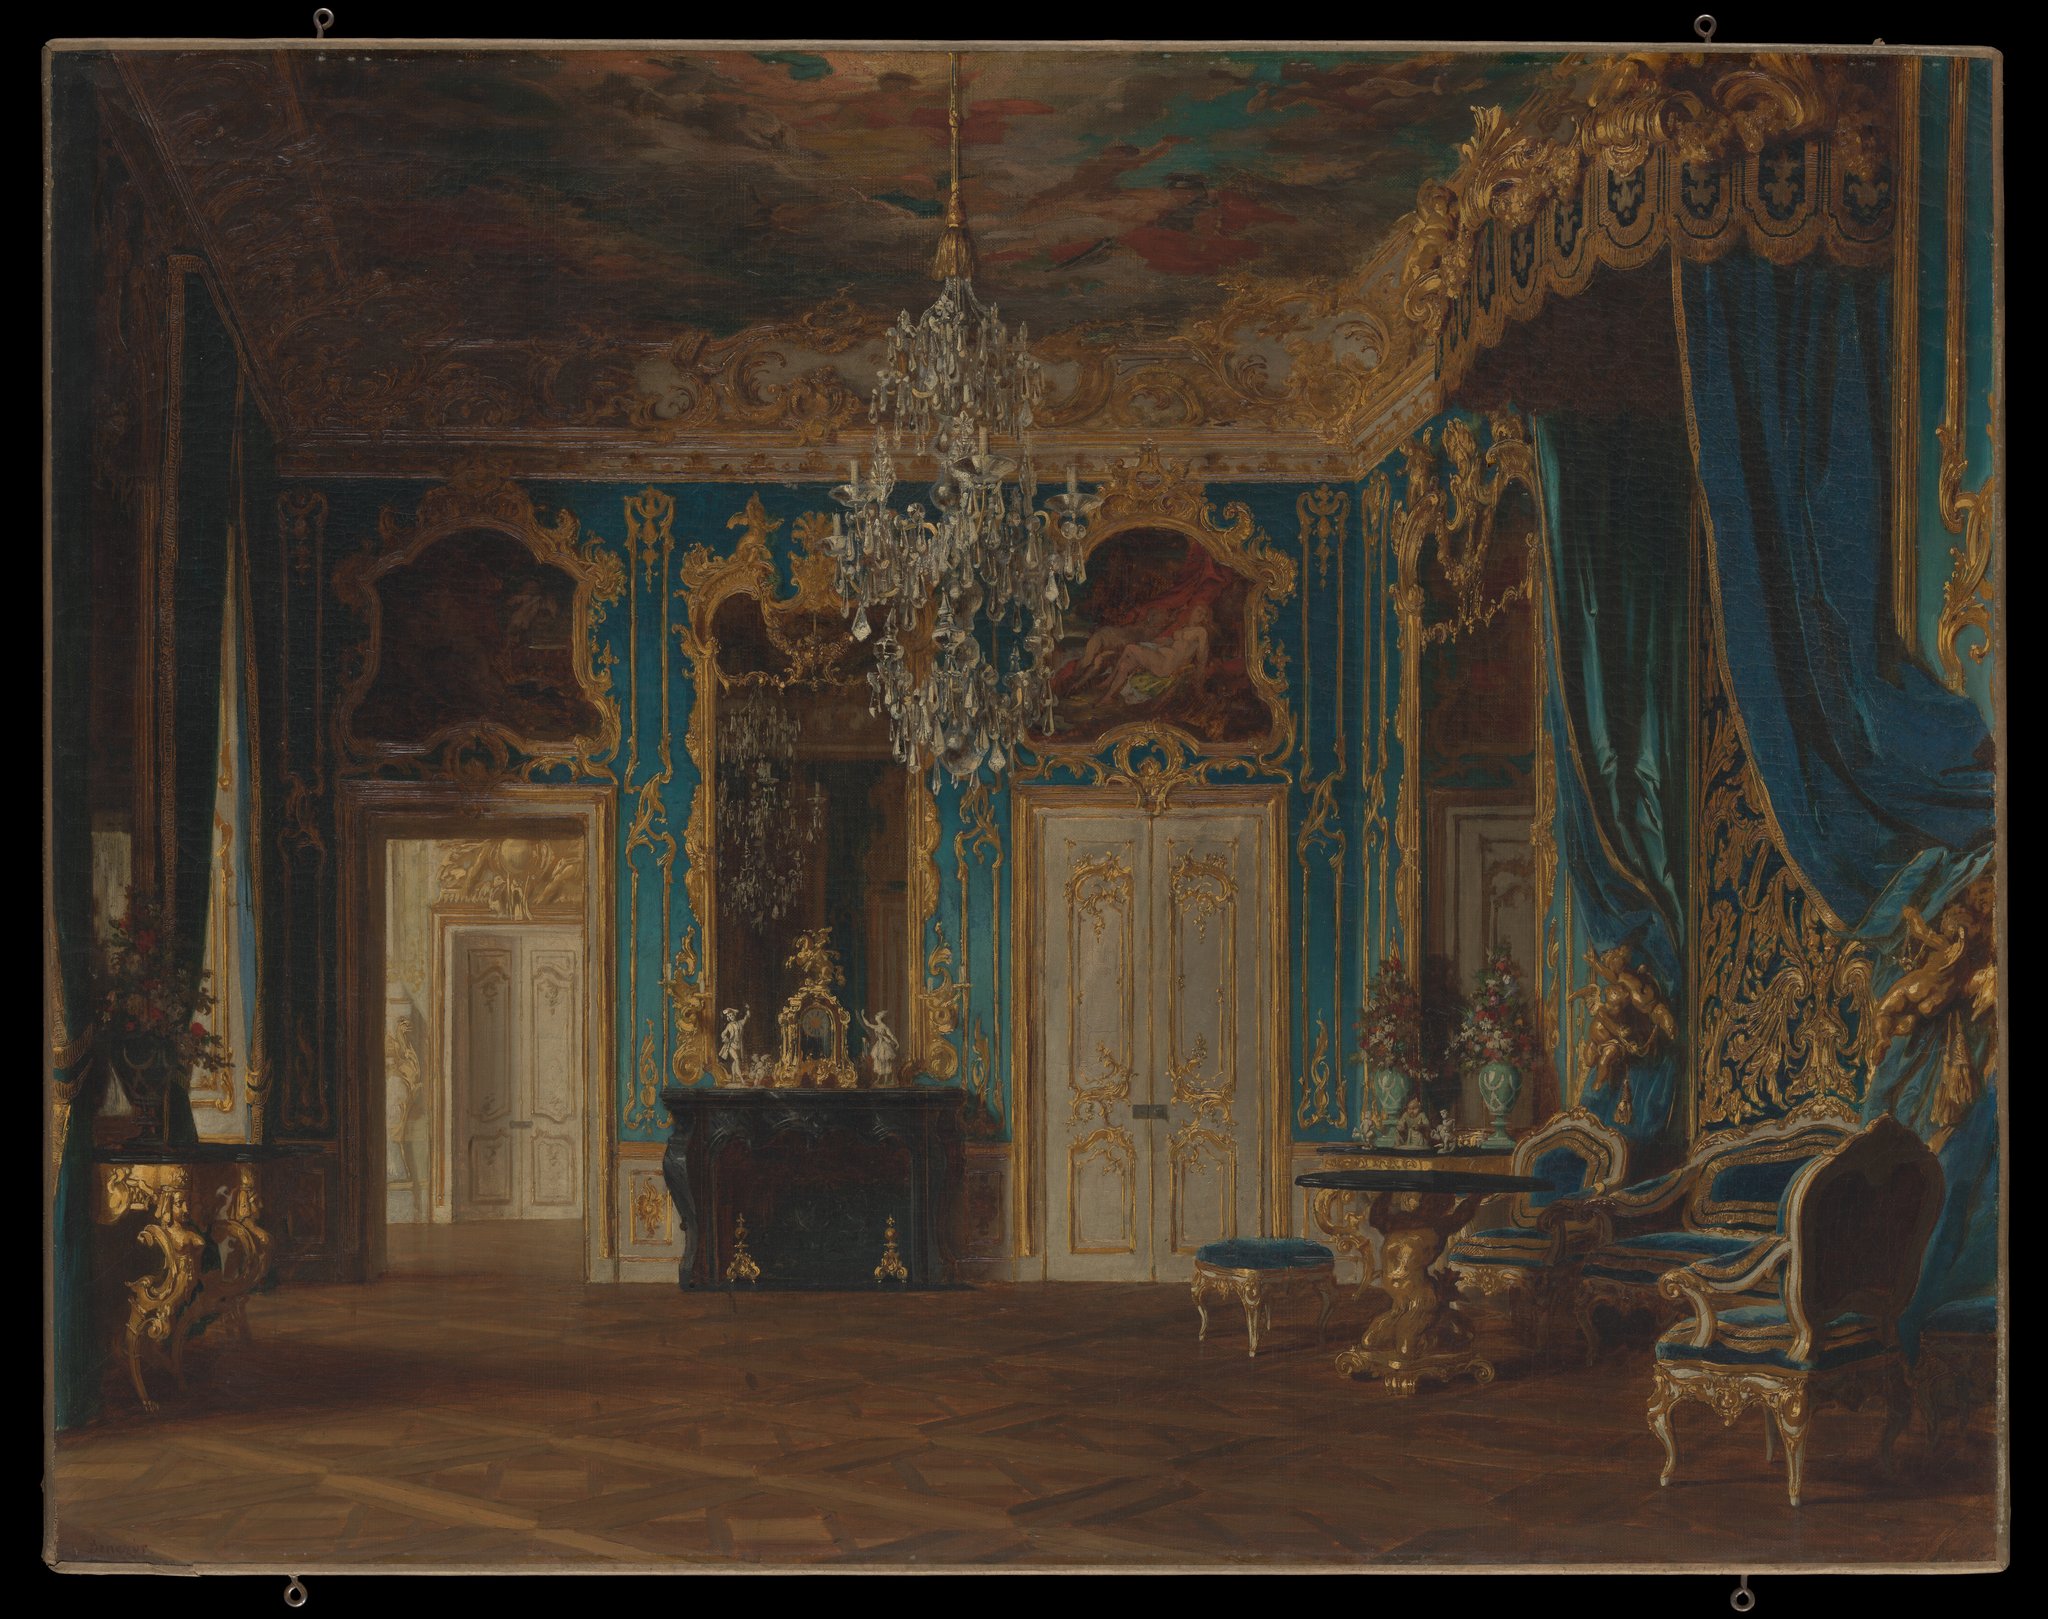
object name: painting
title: Project for a Room for King Ludwig II (1854–1886) of Bavaria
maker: gyula benczúr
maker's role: artist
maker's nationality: hungarian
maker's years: 1844-1920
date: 1864-1920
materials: canvas, oil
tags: interiors,chairs,tables